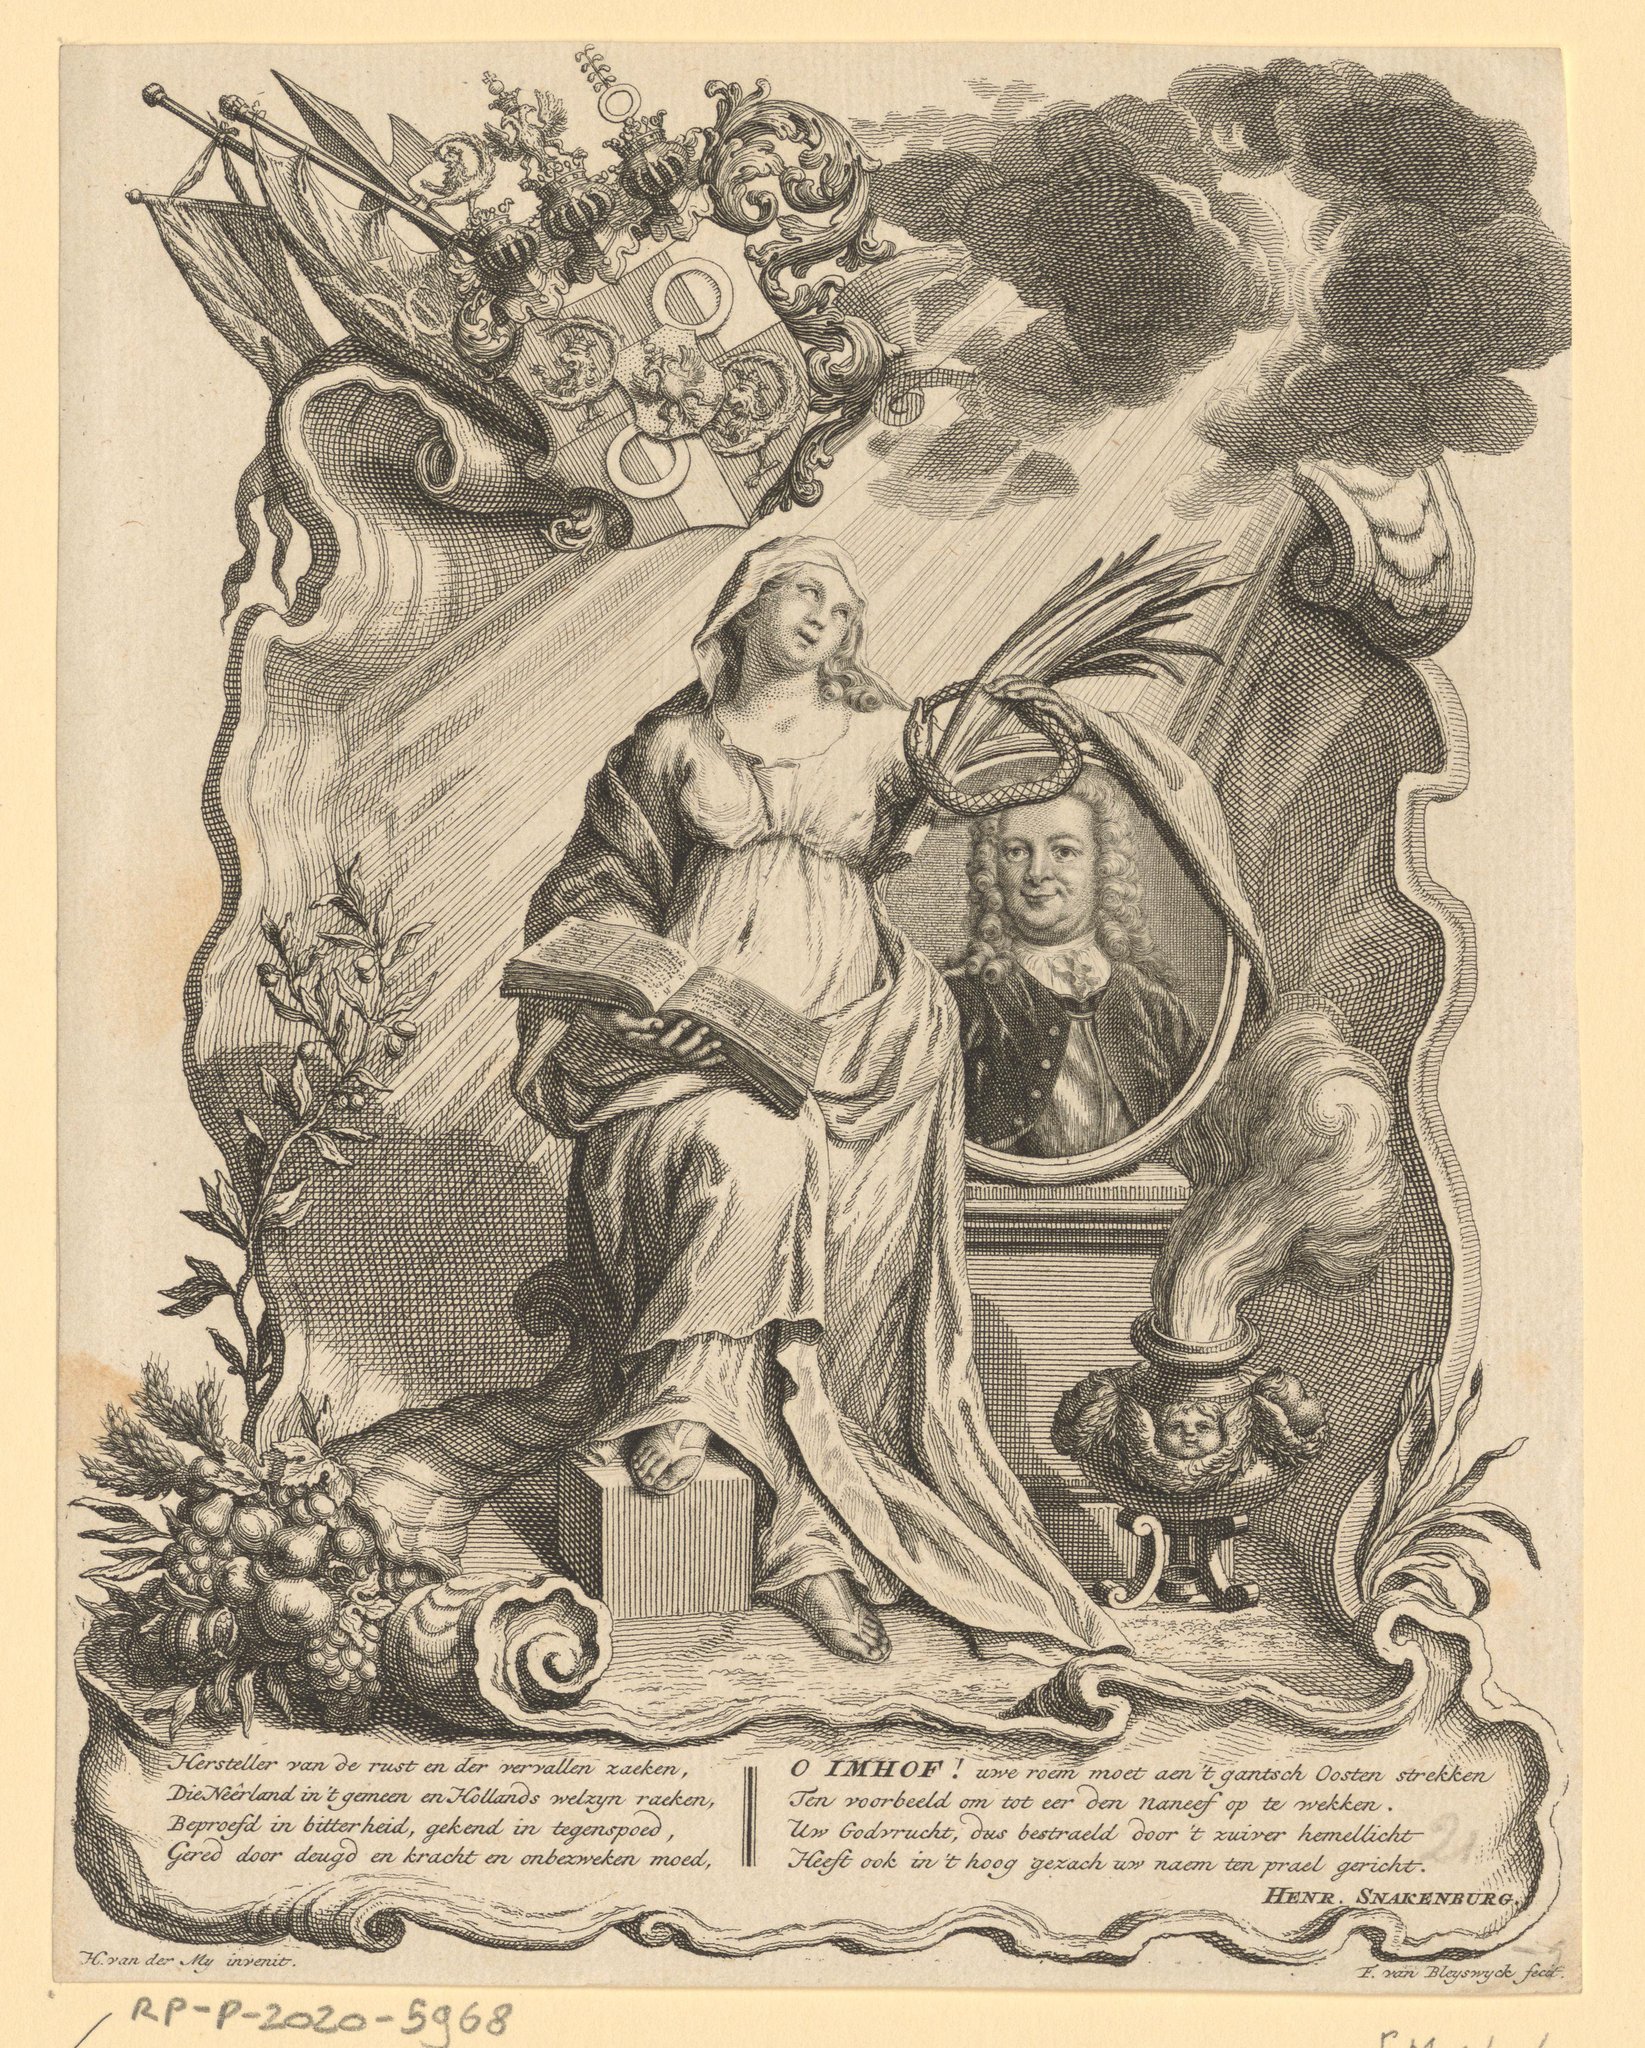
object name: print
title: Portret van baron Gustaaf Willem van Imhoff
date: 1681-1746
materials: paper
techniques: etching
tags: colonial governor, 'cornucopia', horn of plenty, historical persons, armorial bearing, heraldry, abstract ideas and concepts (+ personification)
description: Een vrouwelijke personificatie zit naast een sokkel met het portret van de gouverneur. Zij houdt een palmtak vast en een slang die zichzelf in de staart bijt. Naast haar ligt een hoorn des overvloeds.